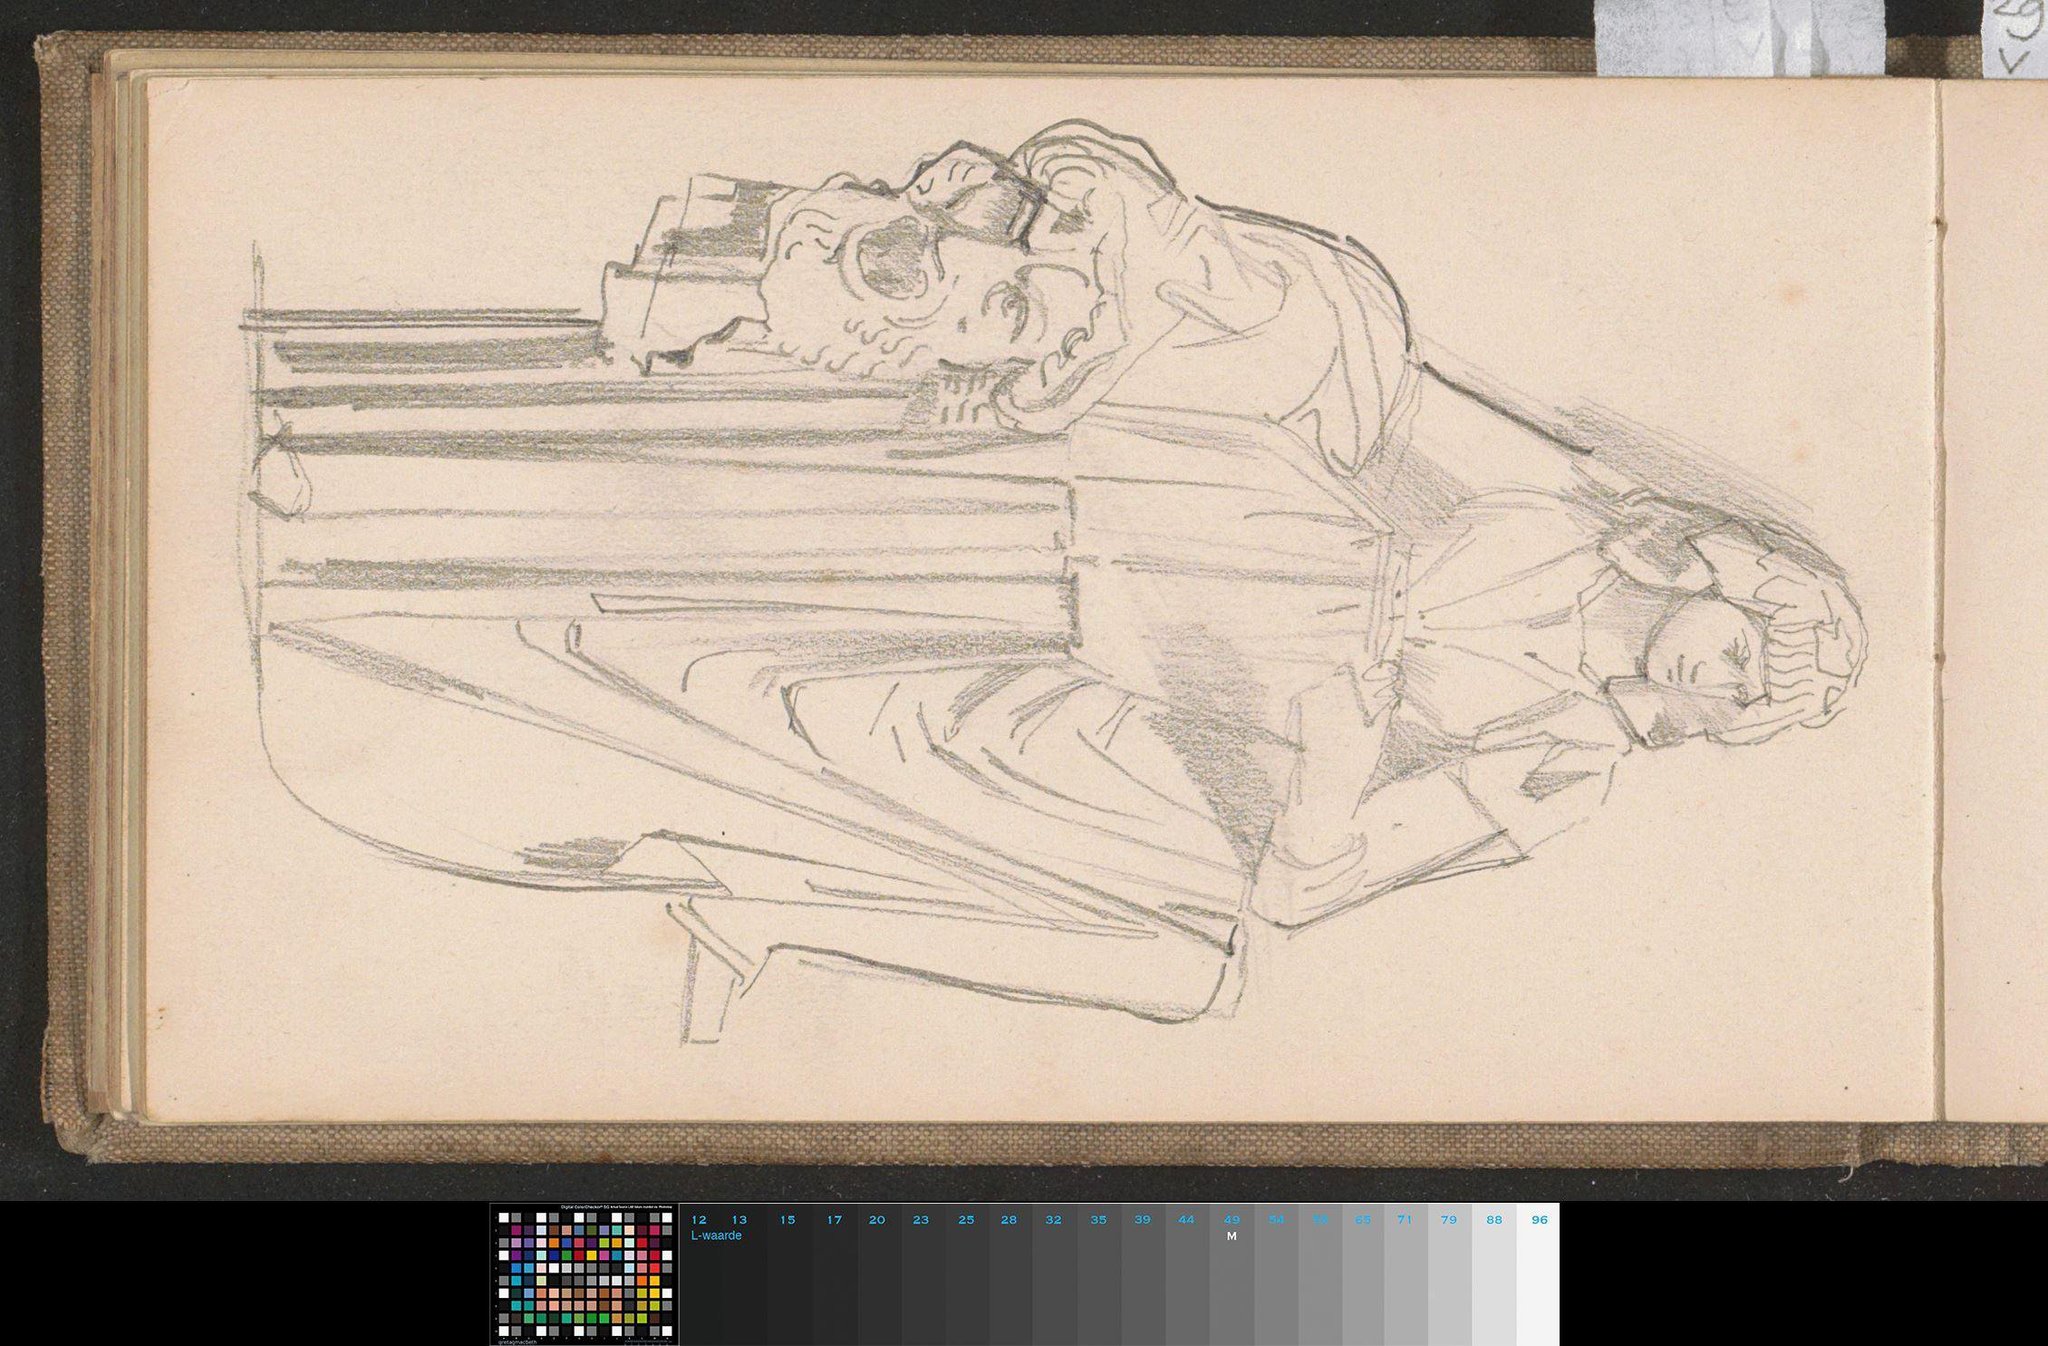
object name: sketchbook leaf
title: Standbeeld van een vrouw met het hoofd van een man in haar hand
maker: antoon derkinderen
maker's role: draughtsman, painter, print maker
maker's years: 1859-1925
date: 1892-1901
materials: paper, pencil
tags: head (human), standing figure - aa - female human figure, sculpture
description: Mogelijk Salome met het hoofd van Johannes de Doper. Blad 24 verso uit een schetsboek met 51 bladen.